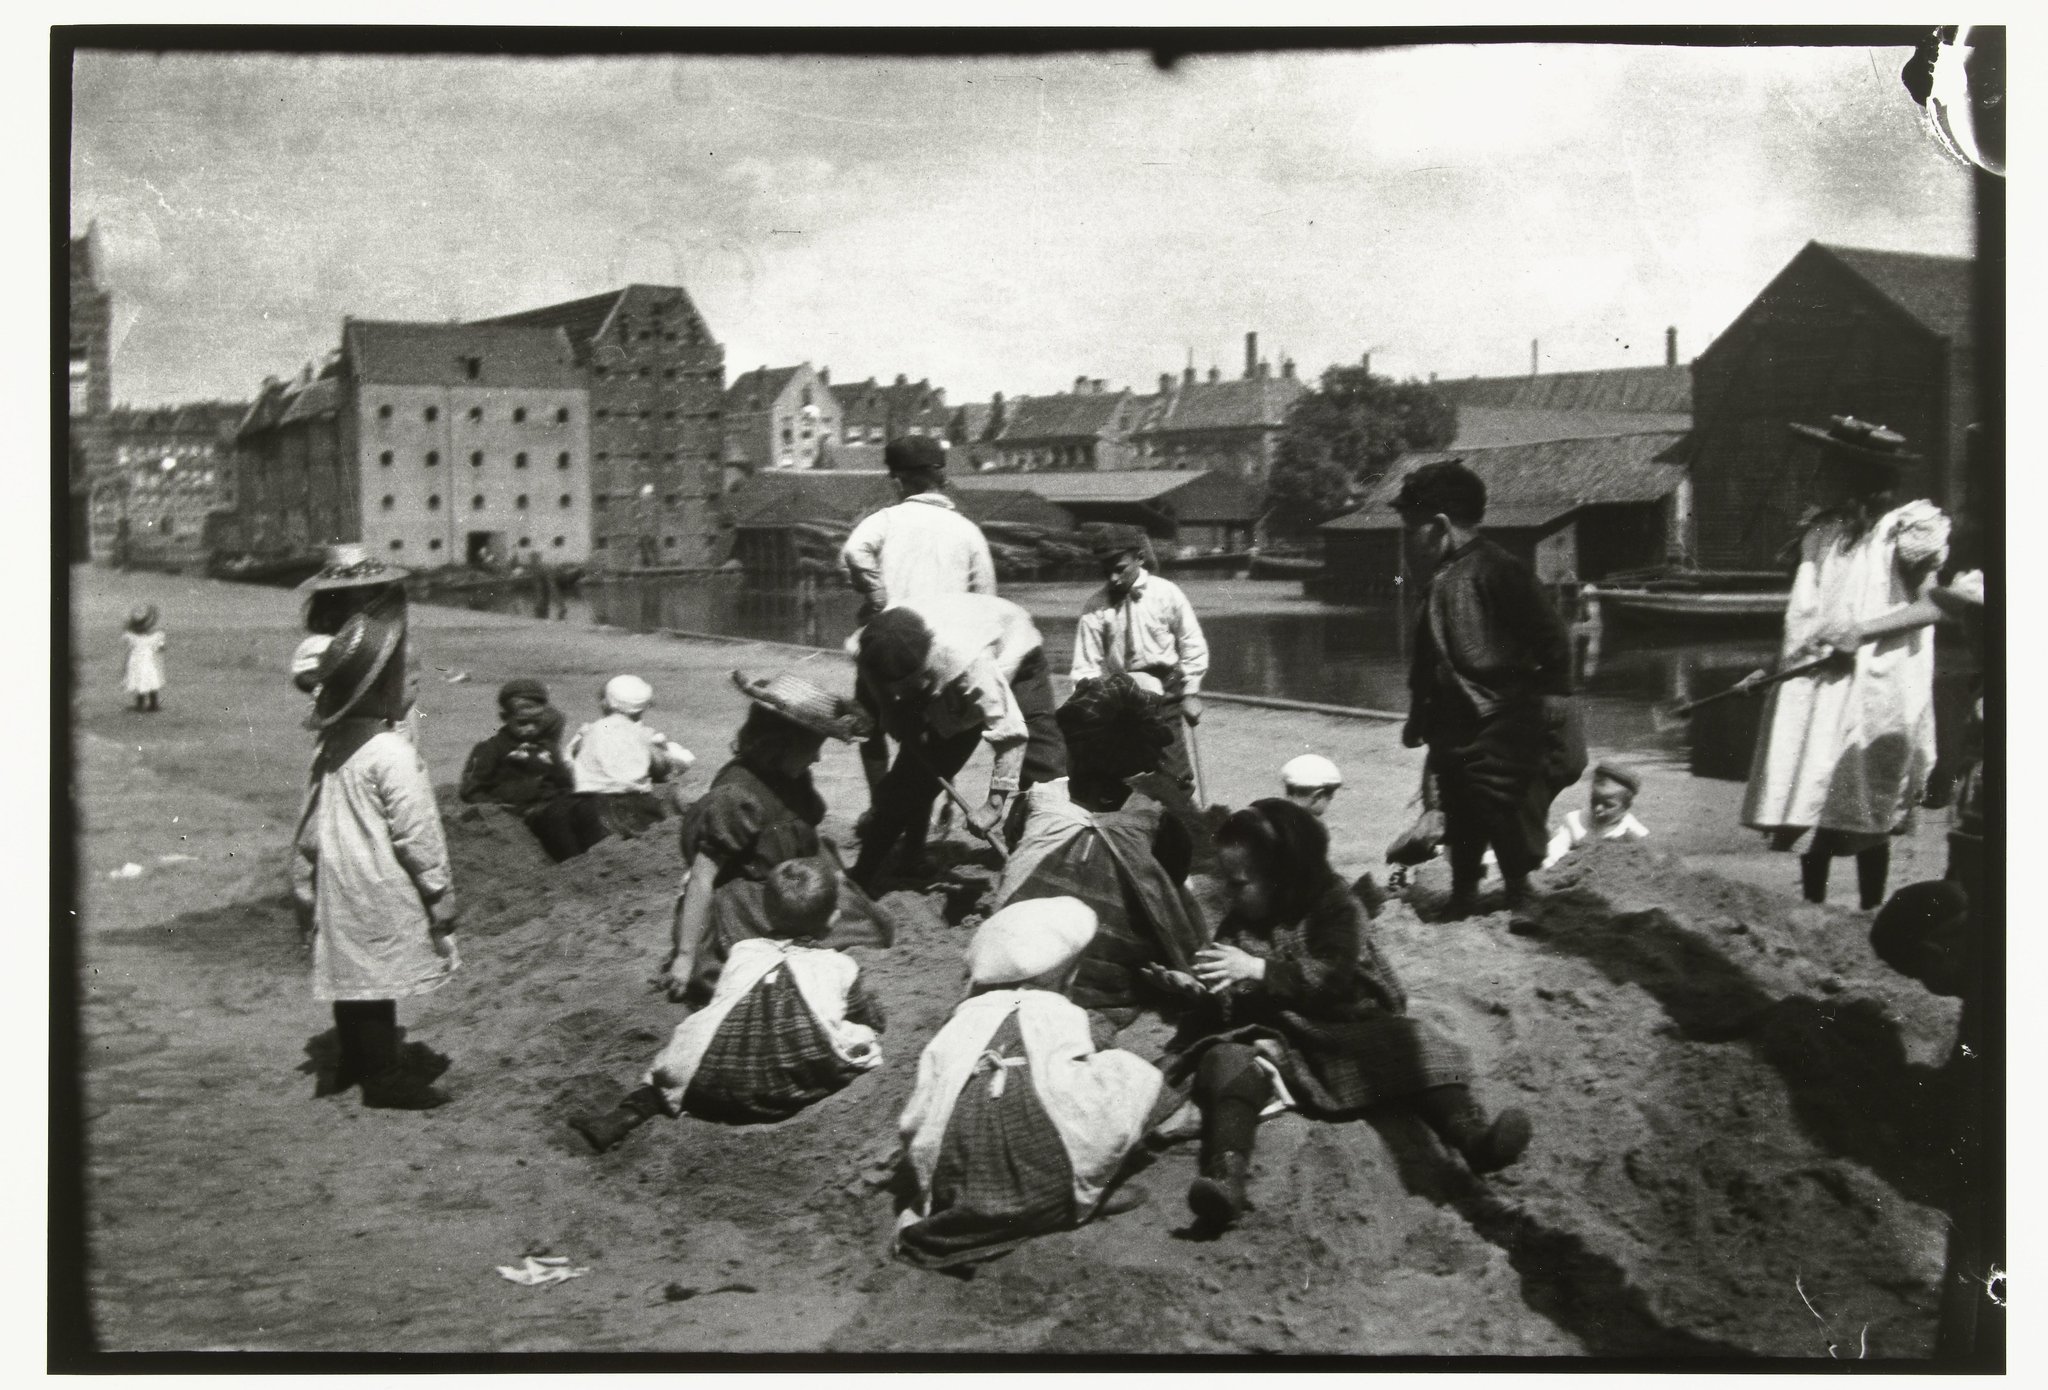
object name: photograph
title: Spelende kinderen in een zandhoop bij het Prinseneiland in Amsterdam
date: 1890-1910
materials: paper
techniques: gelatin silver print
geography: amsterdam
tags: prinseneiland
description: Moderne afdruk van negatief BR 482 (collectie RKD).